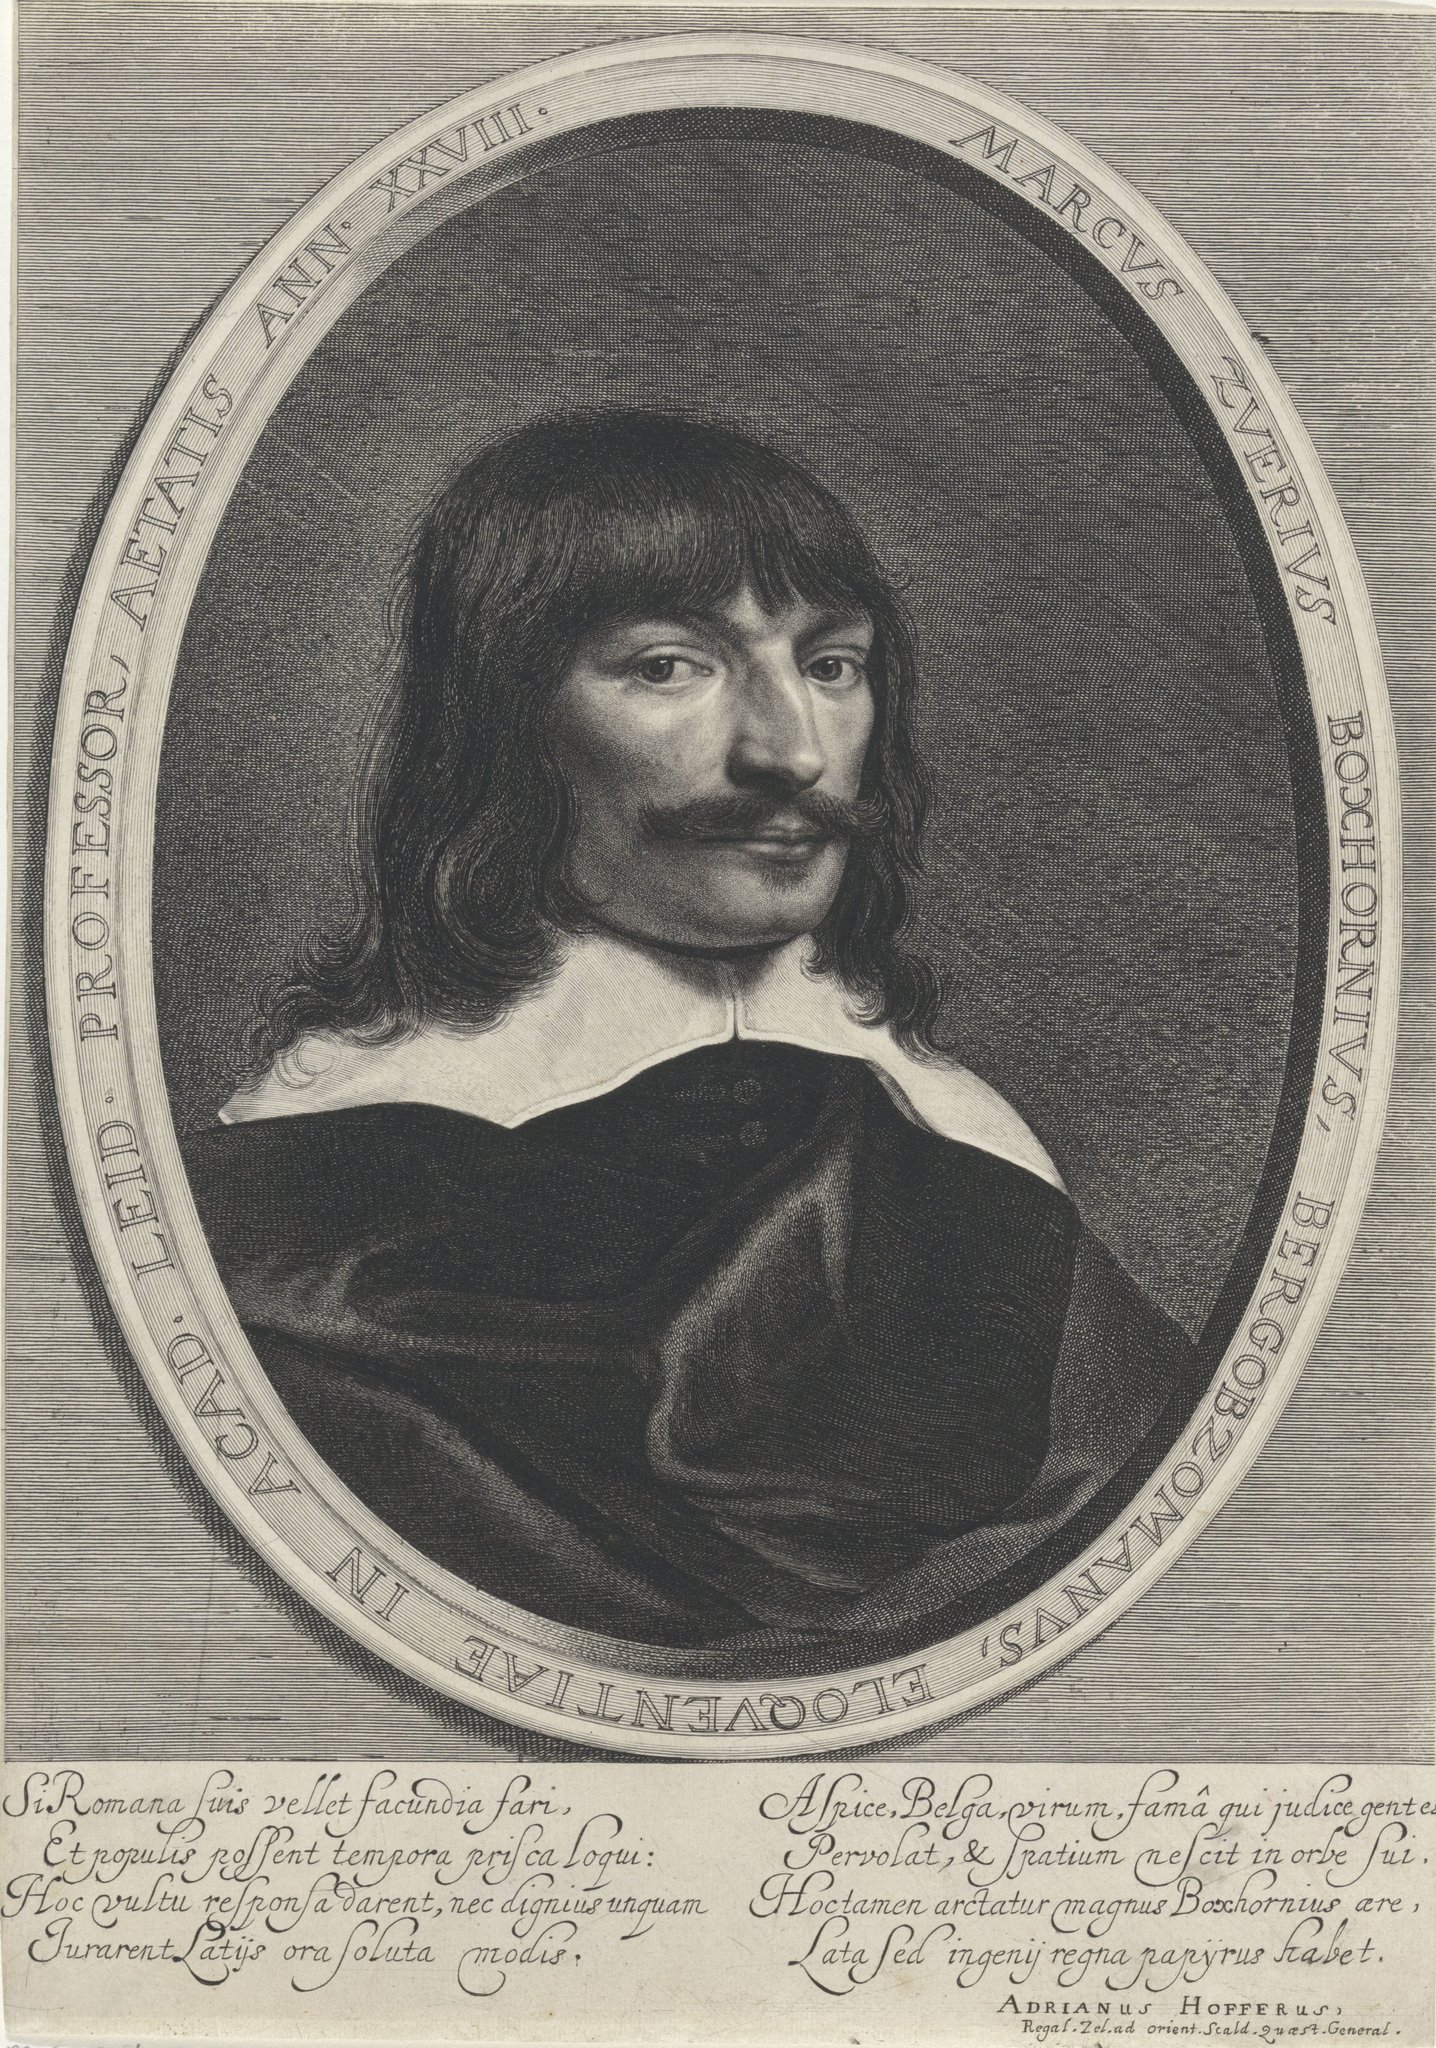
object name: print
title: Portret van Marcus Zuerius Boxhorn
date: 1640-1686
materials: paper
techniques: engraving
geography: haarlem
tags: bergen op zoom, leiden, marcus zuerius boxhorn, historical disciplines; philology (+ portrait of scholar, scientist), professor (+ portrait of teacher, professor)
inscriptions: edge inscription: ‘MARCUS ZUERIUS BOXHORNIUS, BERGOBZOMANUS, ELOQUENTIAE IN ACAD. LEID. PROFESSOR, AETATIS ANN. XXVIII.’, collector's mark: Lugt 240, caption: ‘Si Romana suis vellet facundia fari, Et populis possent tempora prisca loqui: Hoc vultu responsa darent, nec dignius unquam Iurarent Latijs ora soluta modis. Alpice, Belga, virum, famâ qui judice gentes Pervolat, & Spatium nescit in orbe sui, Hoc tamen arctatur magnus Boxhornius are, Lata sed ingenij regna papyrus habet.’, signature: ‘C. Danckertz excud. Adrianus Hofferus, Regal. Zel. ad orient Scald. Quoest. General.’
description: Portret van Marcus Zuerius Boxhorn, hoogleraar welsprekendheid aan de universiteit van Leiden, op 28-jarige leeftijd. Onder het portret een achtregelig vers in het Latijn.